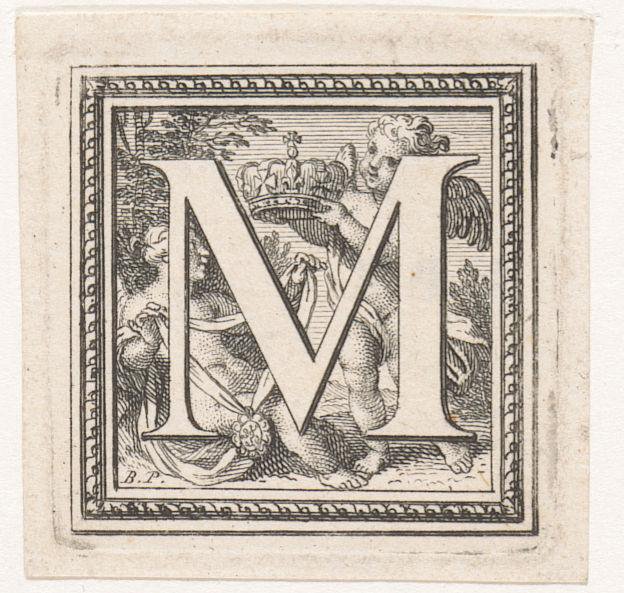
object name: ornament print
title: Letter M en putto met kroon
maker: bernard picart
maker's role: draughtsman, print maker, publisher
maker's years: 1673-1733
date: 1683-1733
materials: paper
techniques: engraving, etching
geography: amsterdam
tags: crown (symbol of sovereignty), historiated initial, cupids: 'amores', 'amoretti', 'putti'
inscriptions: collector's mark: Lugt 2227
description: De letter en het initiaal M met op de achtergrond een putto met een kroon en een naakte vrouw met een sjerp met rozet.